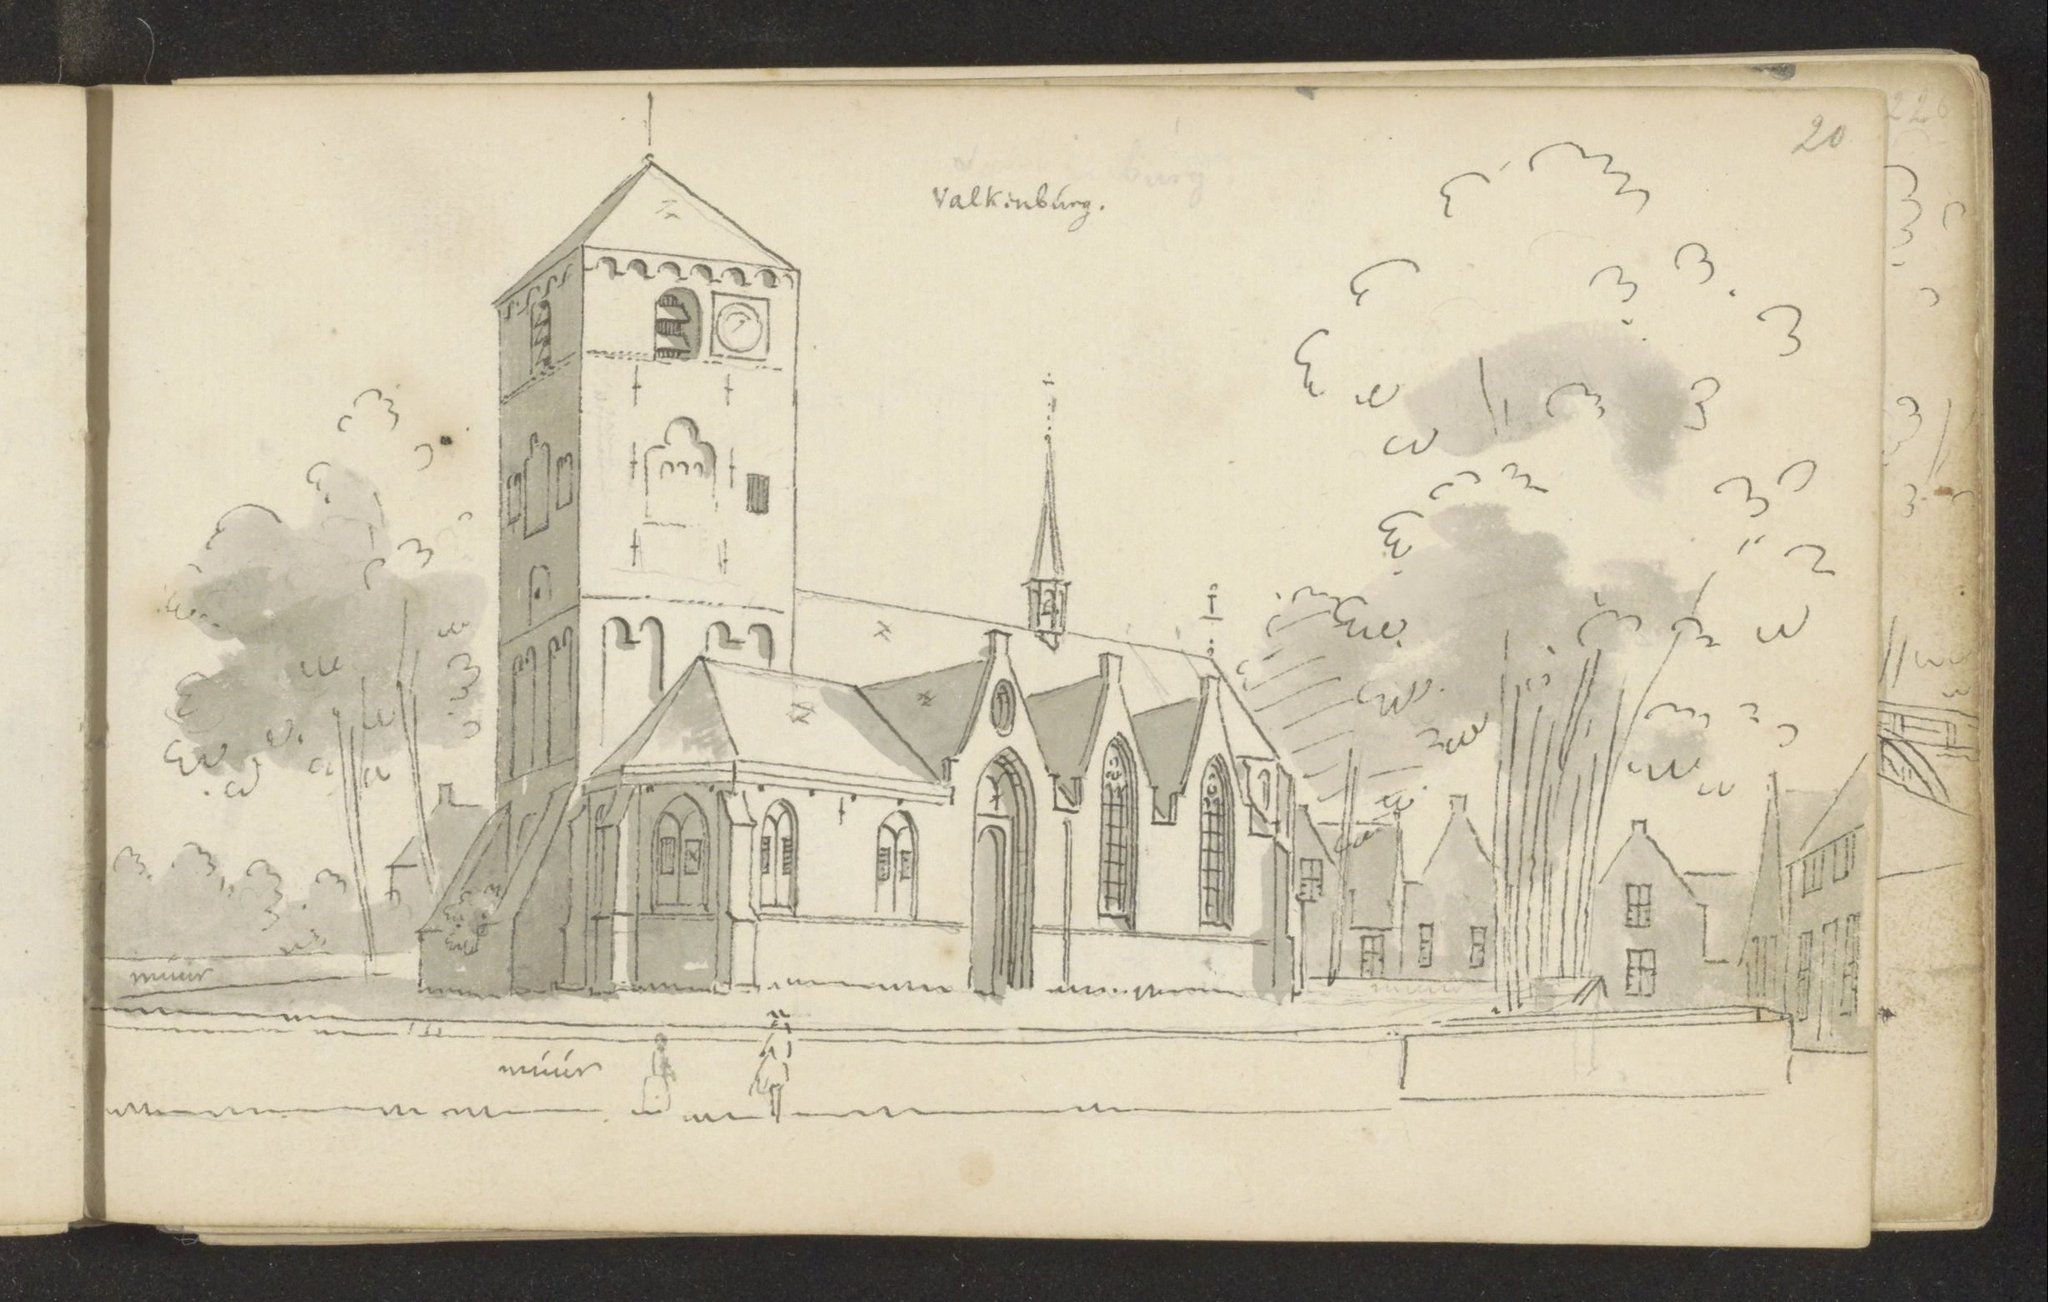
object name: sketchbook leaf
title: Kerk te Valkenburg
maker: abraham de haen (ii)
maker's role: draughtsman, print maker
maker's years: 1707-1748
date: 1731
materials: ink, paper, pencil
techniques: brush, pen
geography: valkenburg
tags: village, church (exterior)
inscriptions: annotation: ‘Valkenburg’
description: Blad 20 recto uit een schetsboek met 78 bladen.